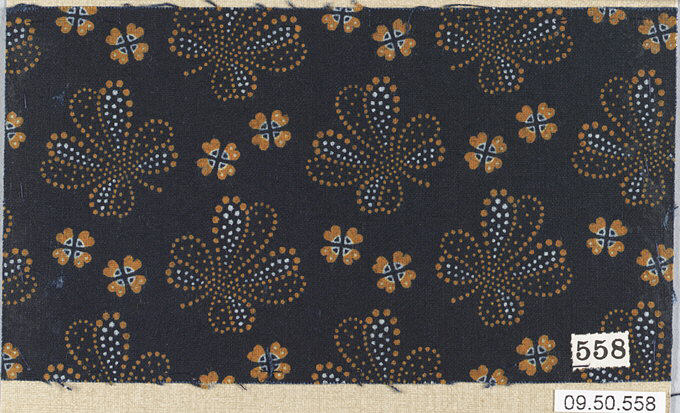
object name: piece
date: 1801-1900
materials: cotton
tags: flowers